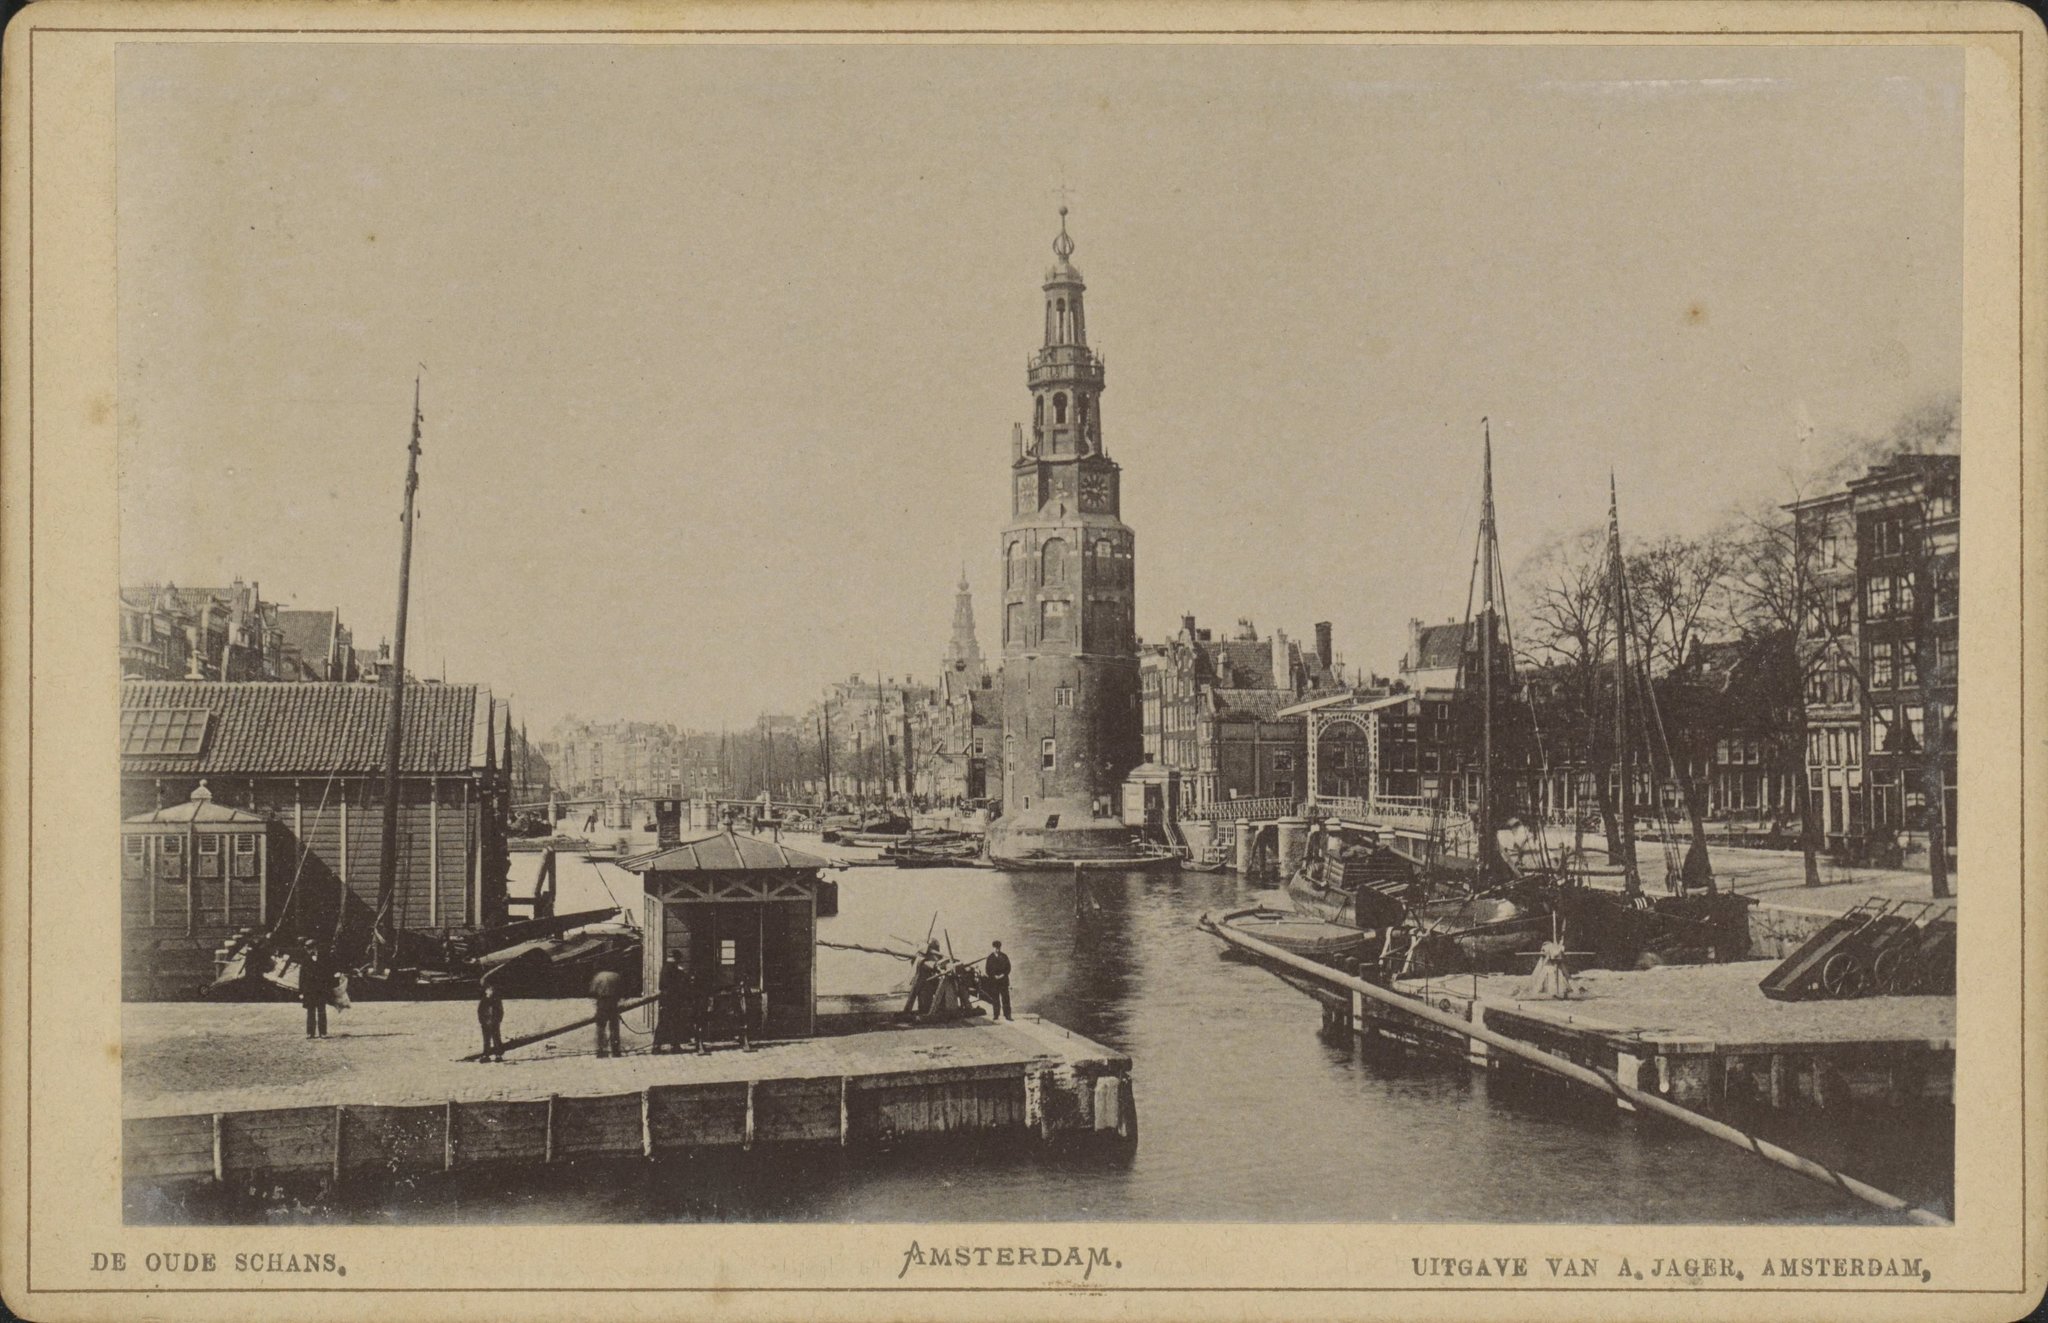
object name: photograph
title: Oudeschans en Montelbaanstoren, gezien vanaf de oever van het IJ, Amsterdam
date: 1880-1895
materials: cardboard, paper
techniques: photograph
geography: amsterdam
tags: oudeschans, montelbaanstoren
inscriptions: inscription: ‘DE OUDE SCHANS. AMSTERDAM. UITGAVE VAN A. JAGER, AMSTERDAM,’